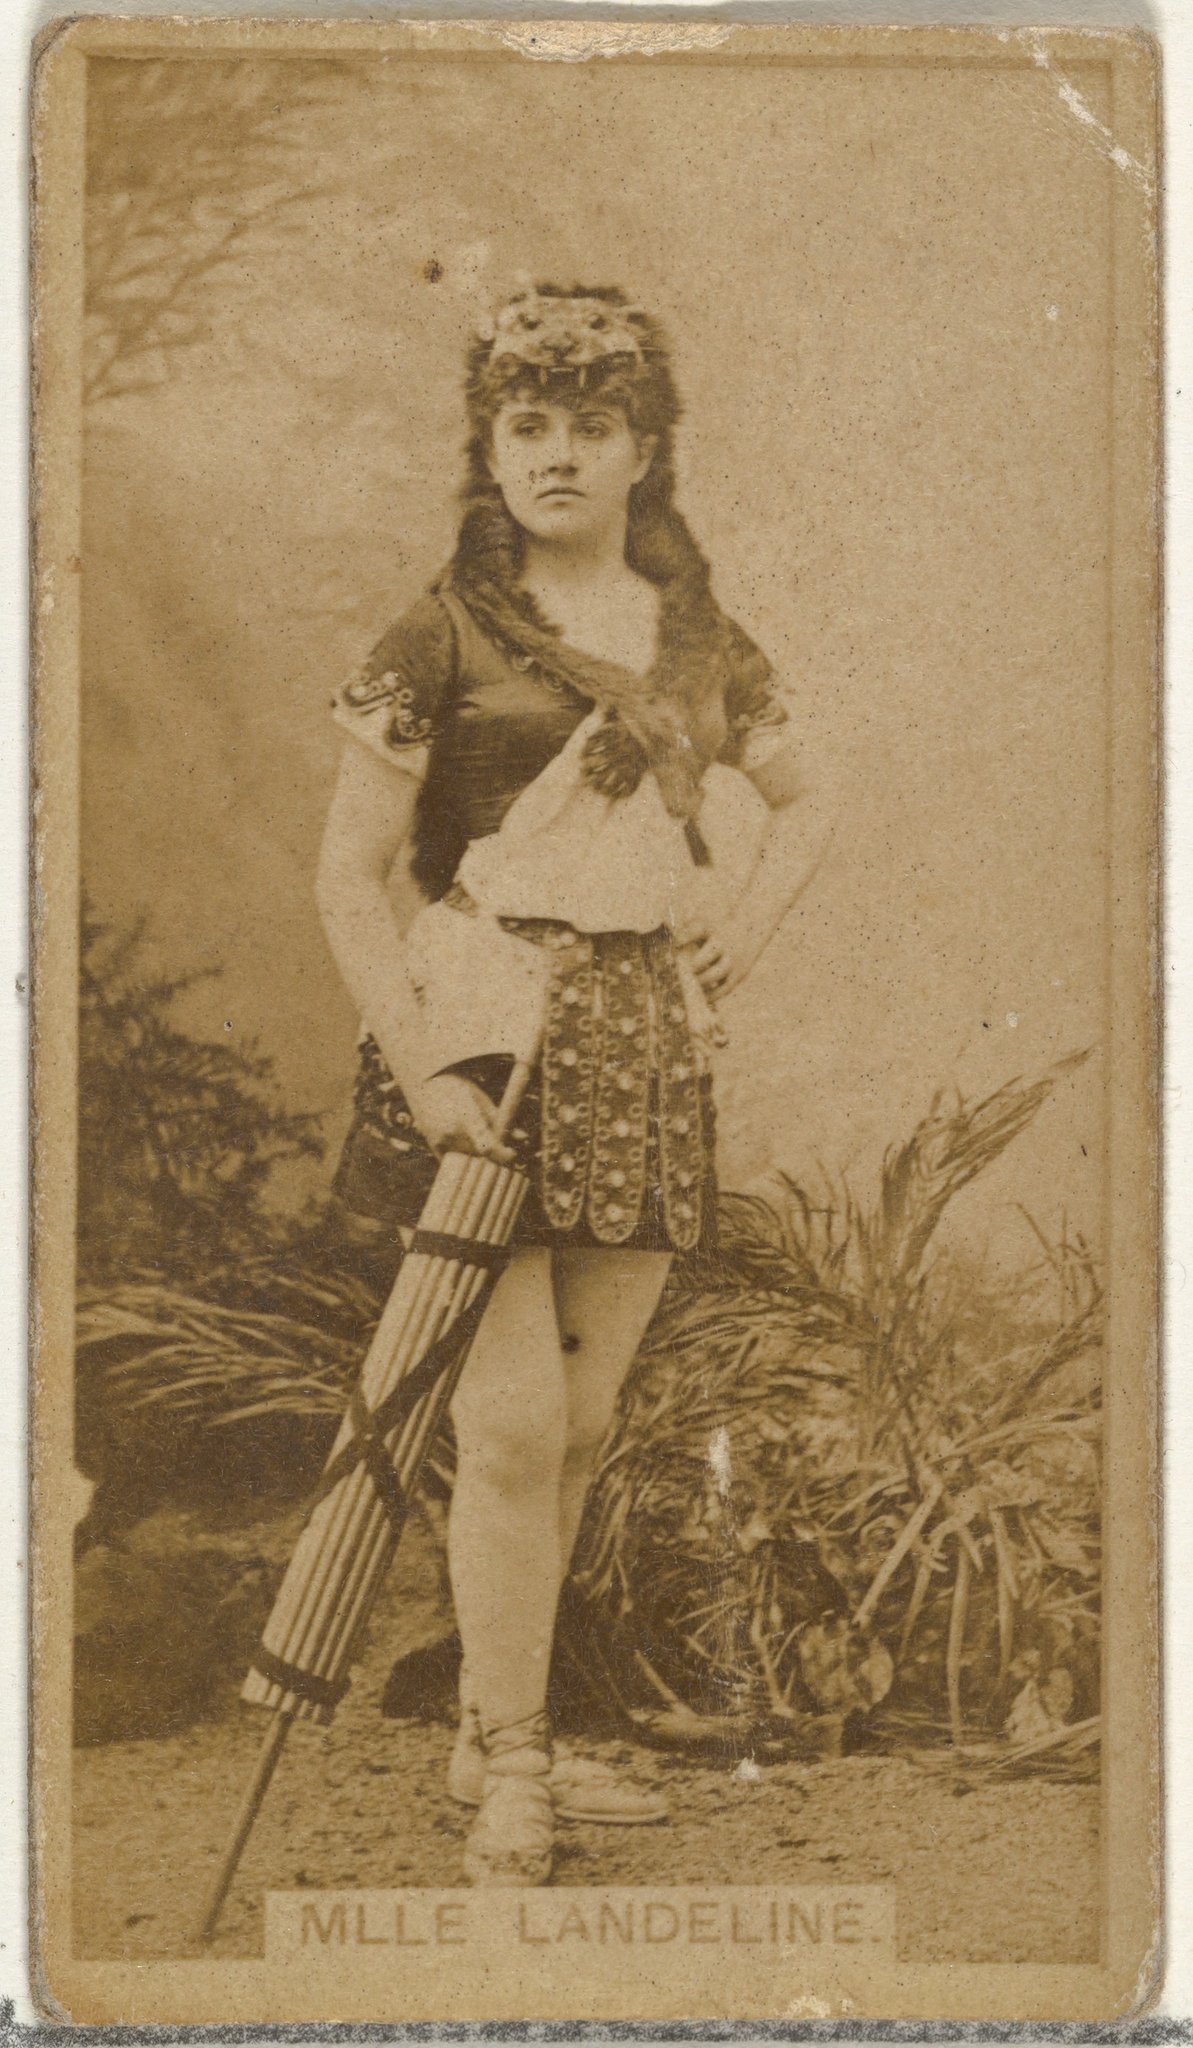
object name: photograph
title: Mlle. Landeline, from the Actors and Actresses series (N145-8) issued by Duke Sons & Co. to promote Duke Cigarettes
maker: w. duke, sons & co.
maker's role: publisher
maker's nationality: american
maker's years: 1870-1920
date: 1891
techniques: albumen silver print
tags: portraits,women,actresses